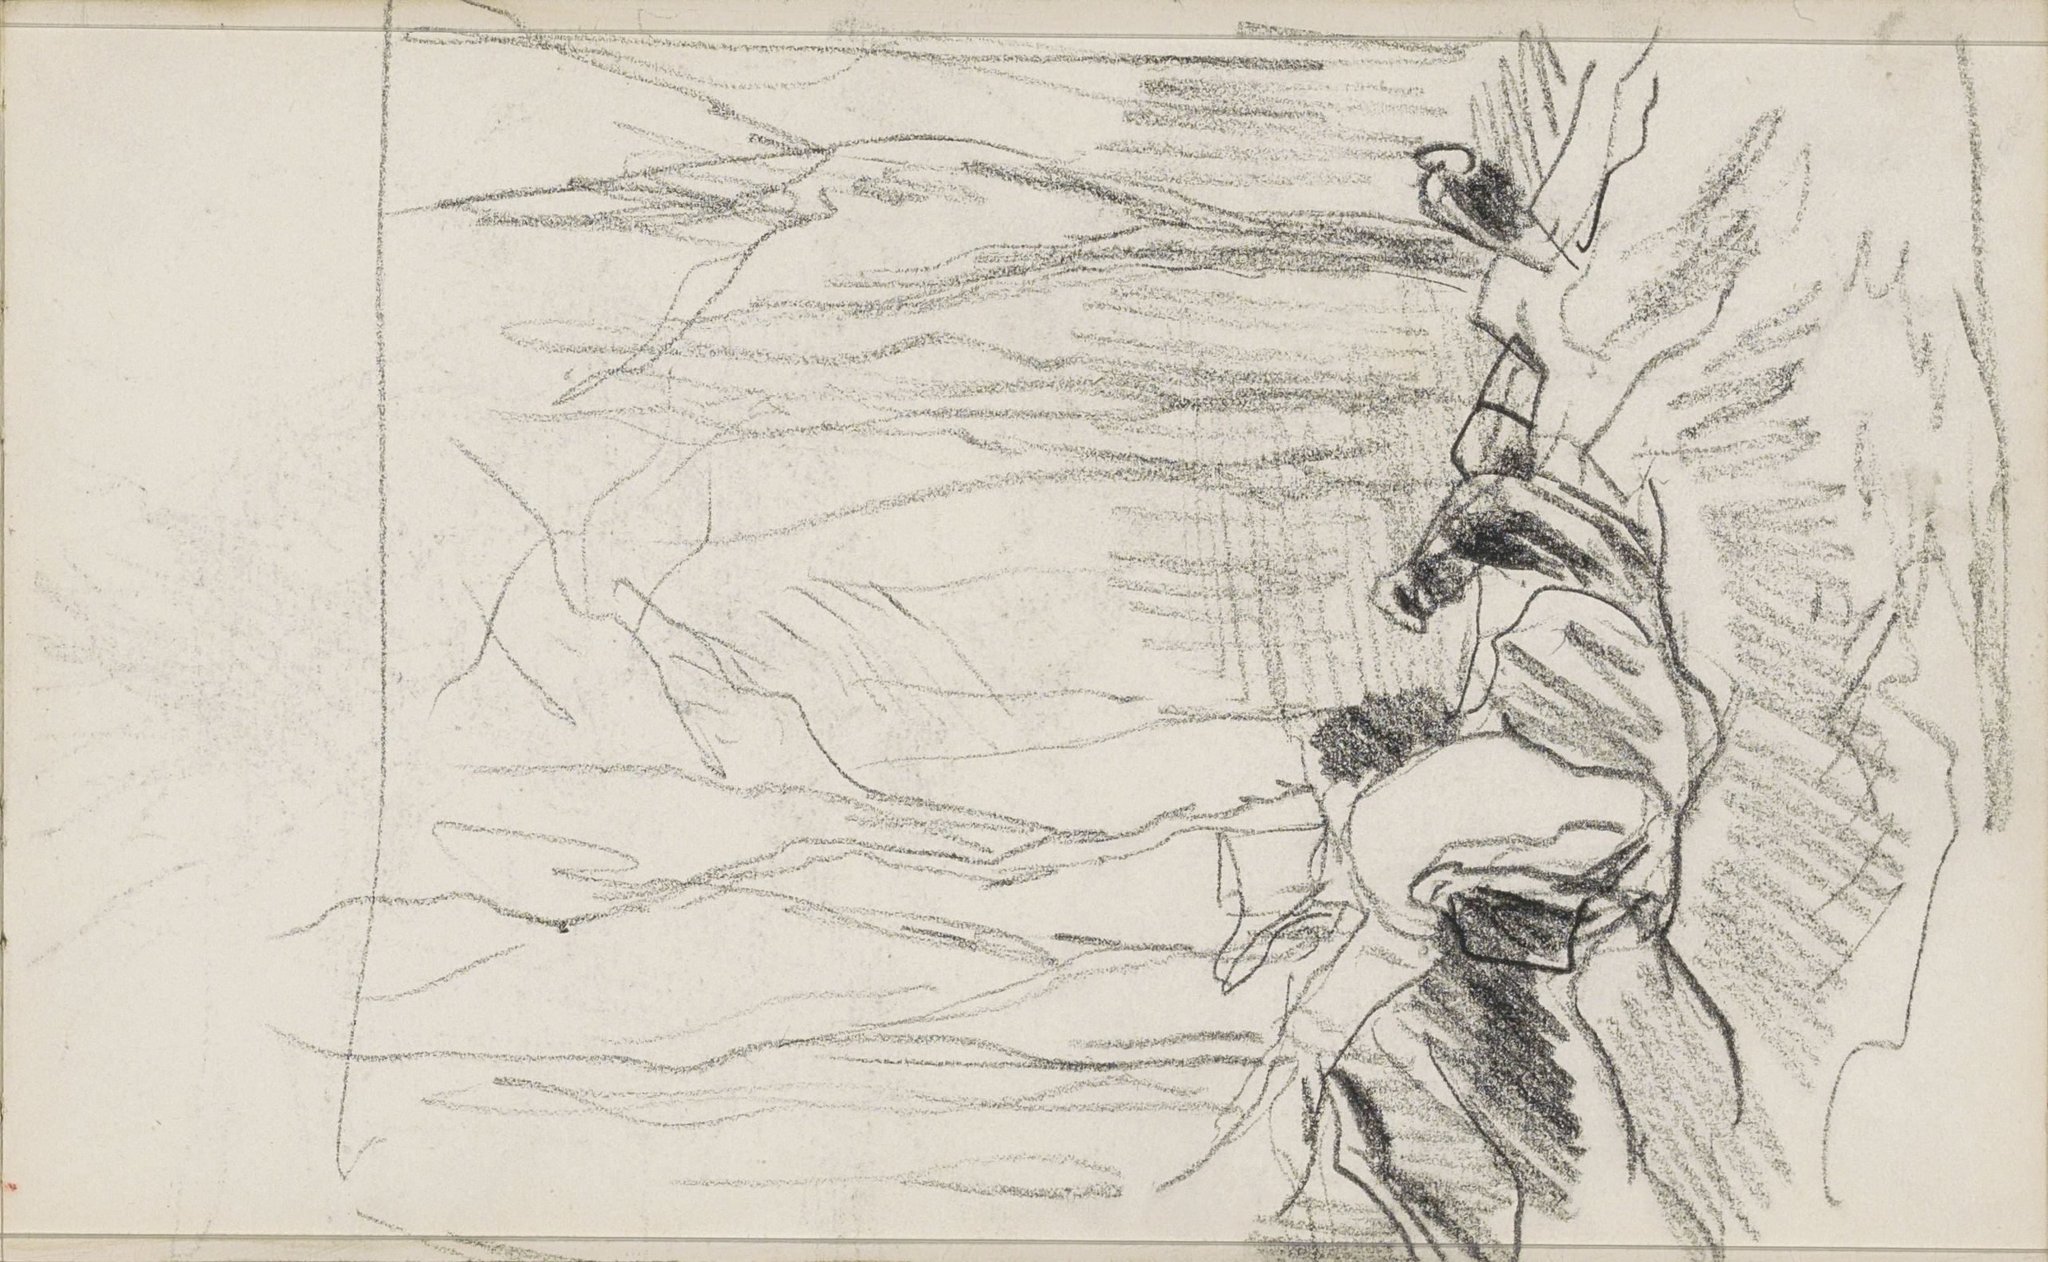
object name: sketchbook leaf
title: Houthakkers bij een omgehakte boom in een bos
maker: anton mauve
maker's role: draughtsman, painter, print maker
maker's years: 1838-1888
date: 1848-1888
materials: chalk, paper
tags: woodcutting, woodcutter ~ forestry, trees (+ stem, trunk), forest, wood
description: Blad 18 recto uit een schetsboek met 41 bladen.